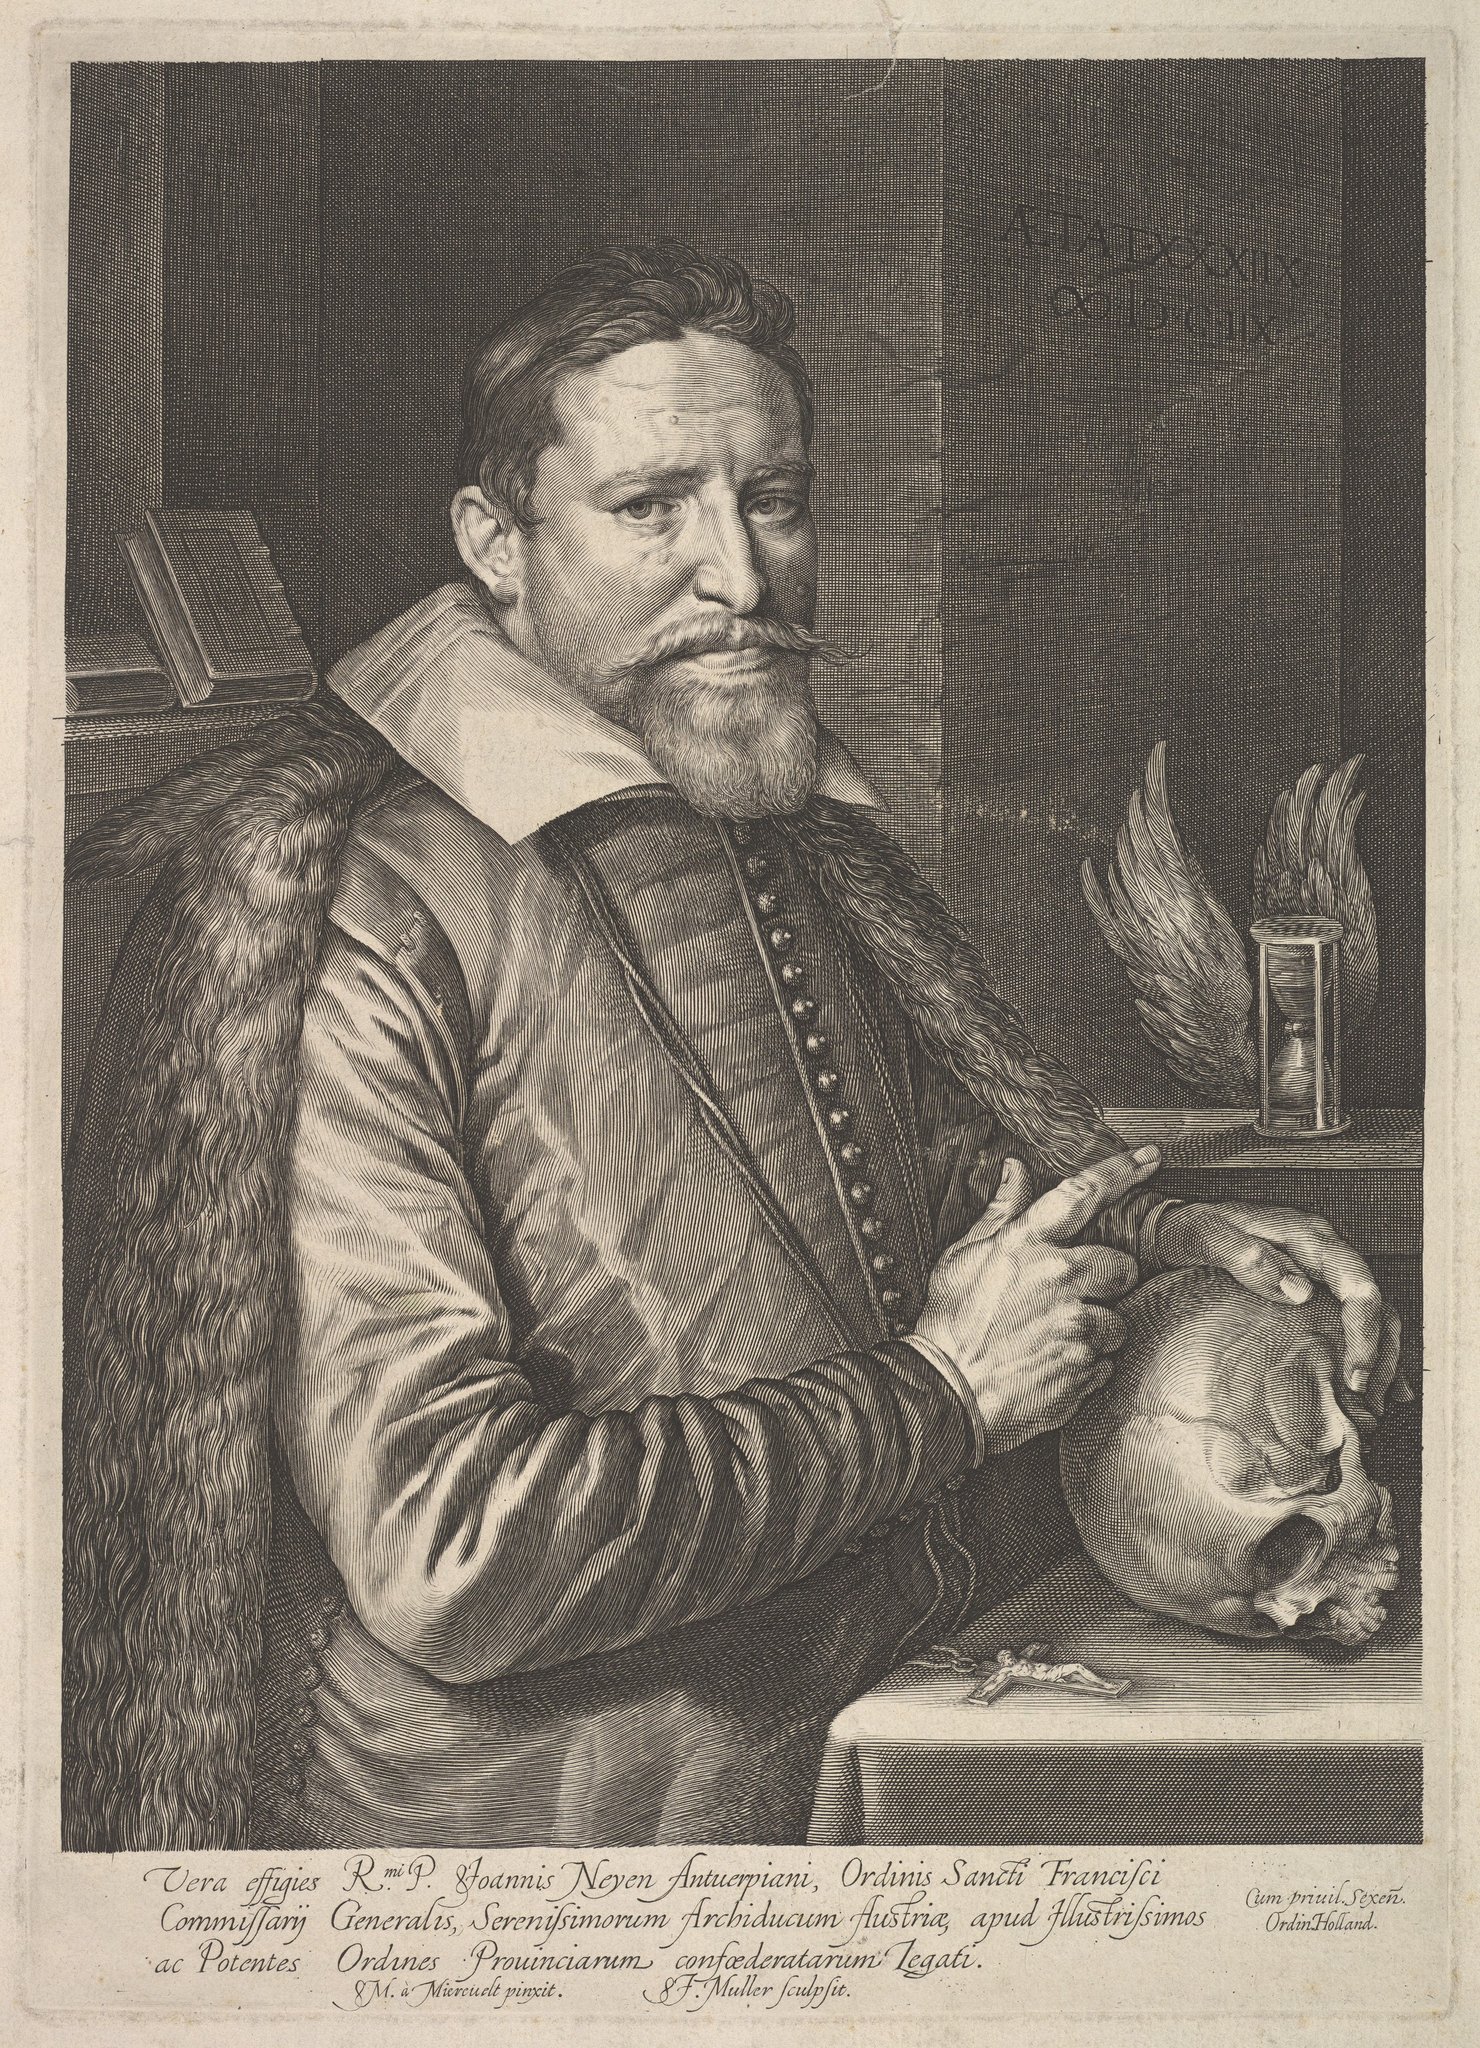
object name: print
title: Portrait of Joannes Neyen, General of the Order of Franciscan Friars, Ambassador in Trier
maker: jan muller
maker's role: artist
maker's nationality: netherlandish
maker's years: 1571-1628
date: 1608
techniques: engraving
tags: skulls,men,portraits